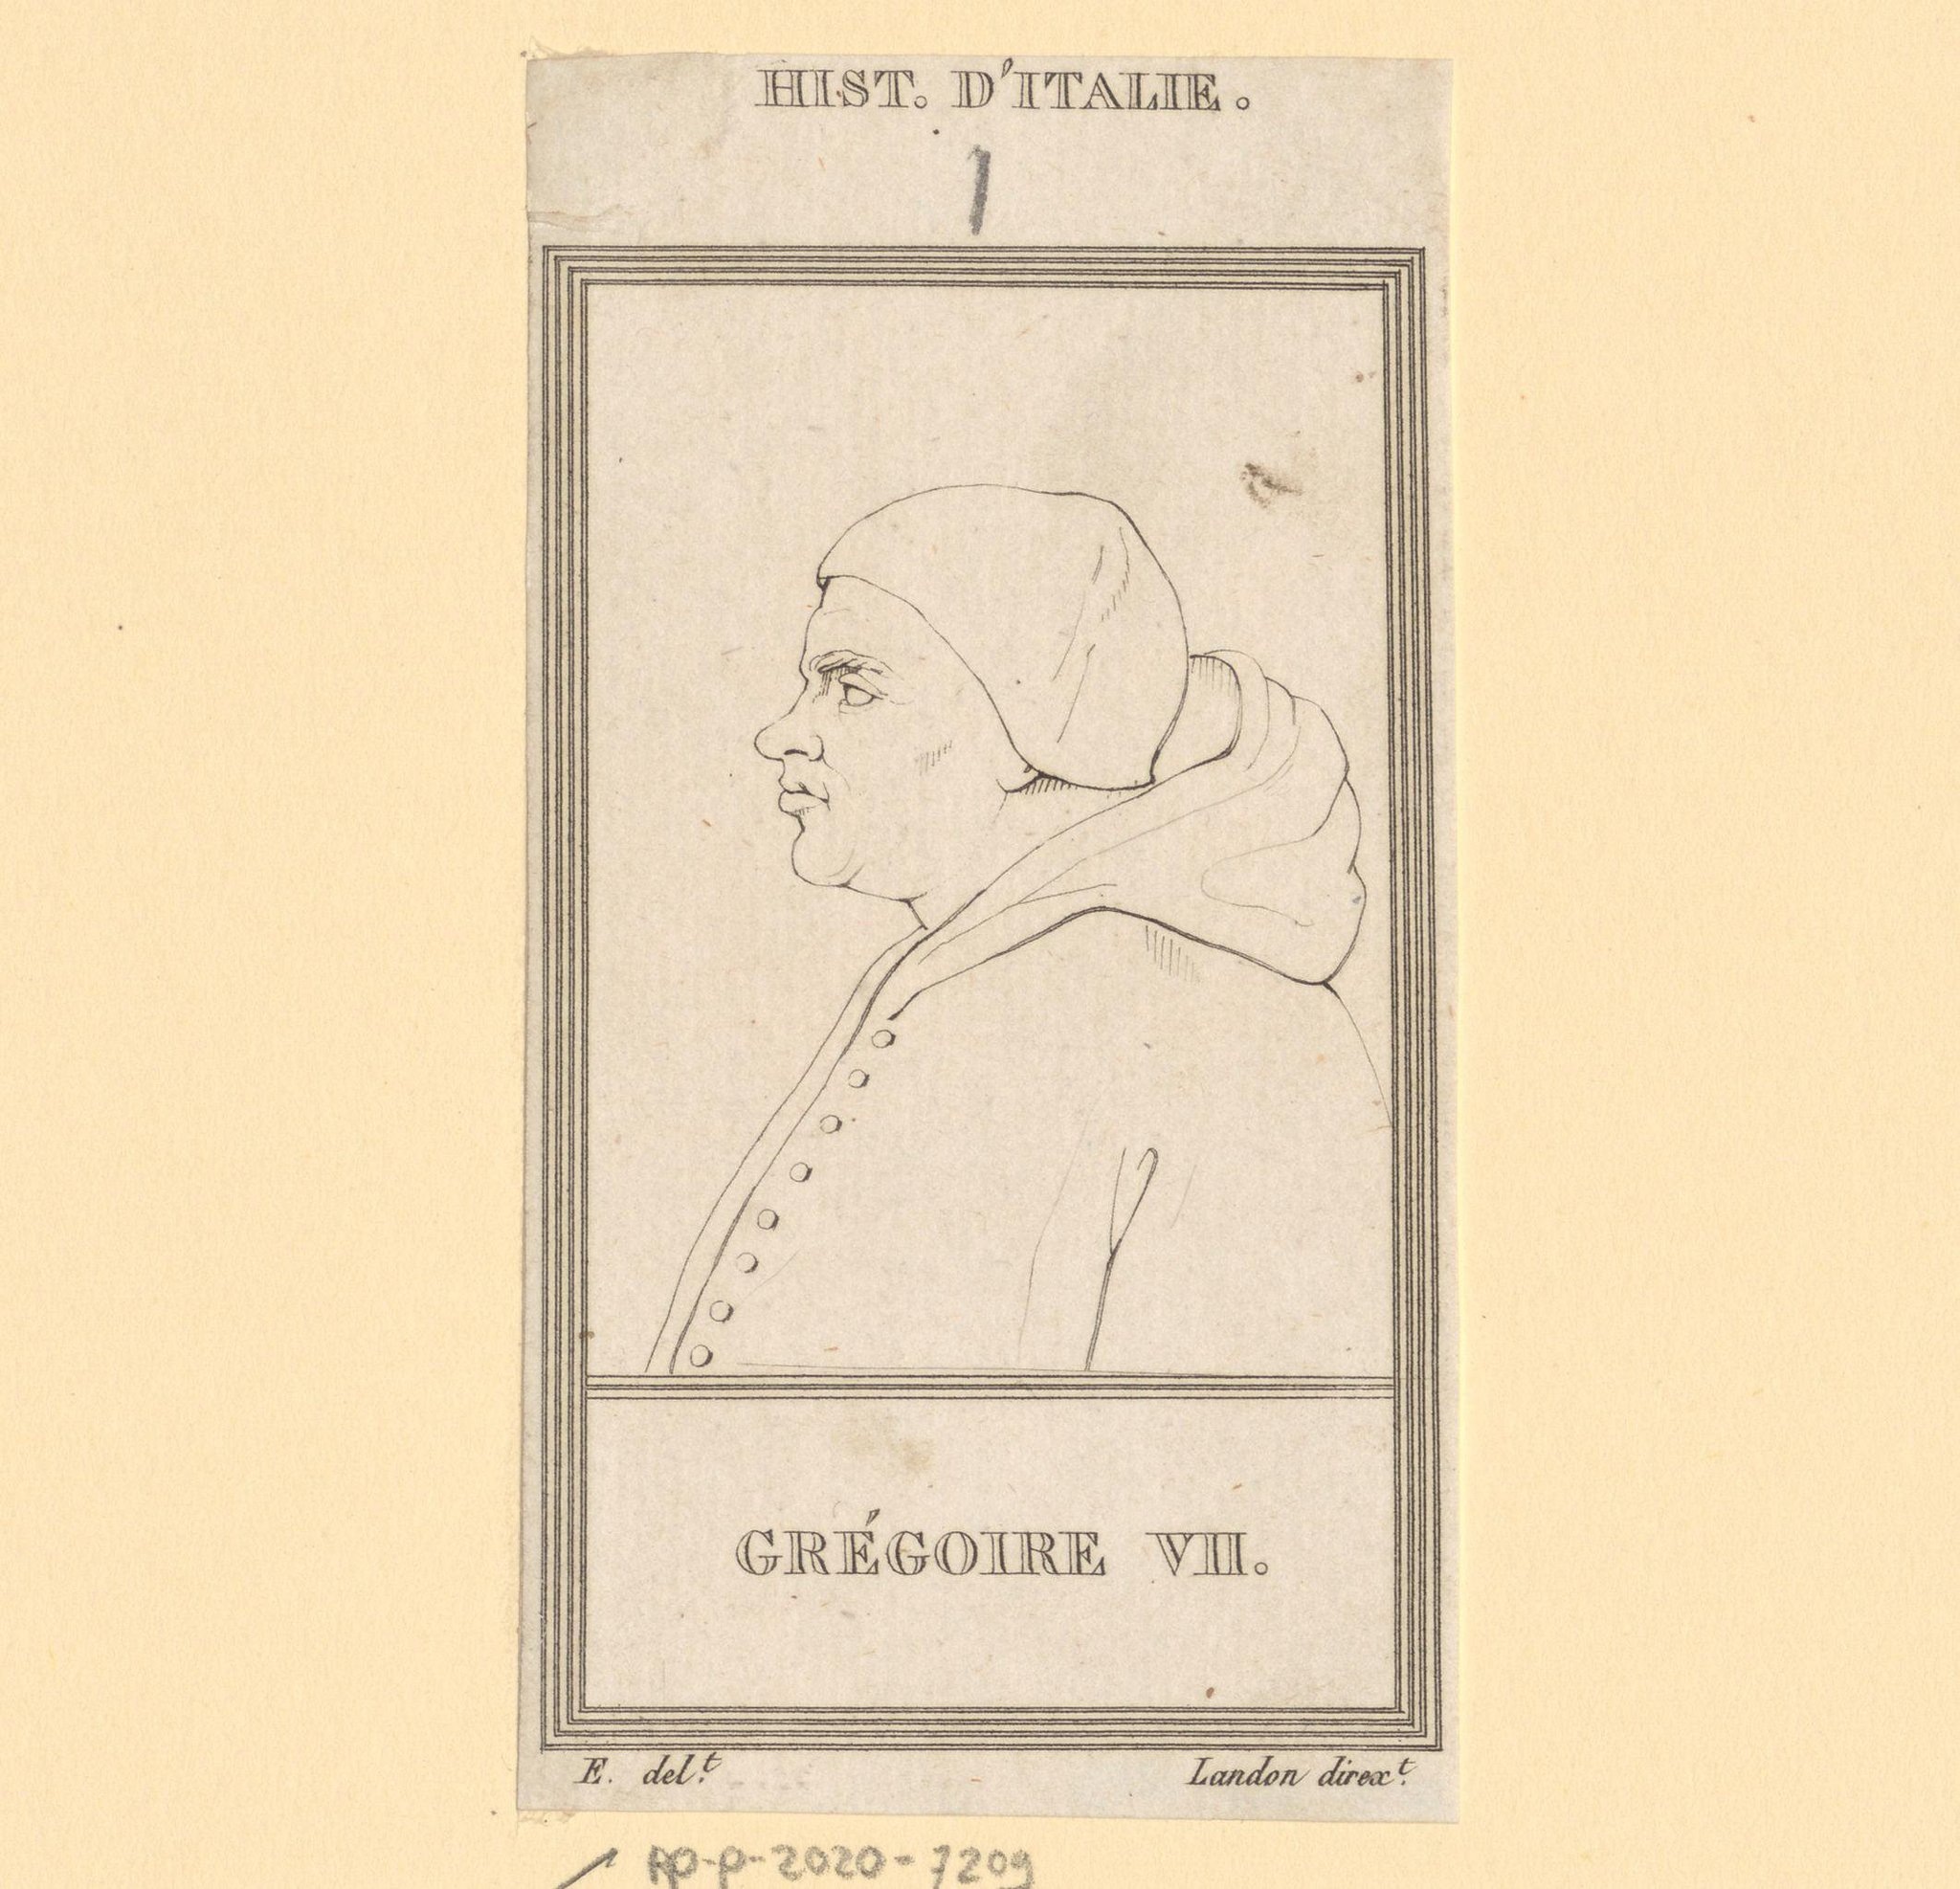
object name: print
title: Portret van paus Gregorius VII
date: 1805-1811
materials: paper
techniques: etching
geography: paris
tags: salerno, historical persons, pope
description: Prent uit: Galerie historique des hommes les plus celebres de tous les siecles et de toutes les nations. Parijs: Charles Paul Landon, 1805.